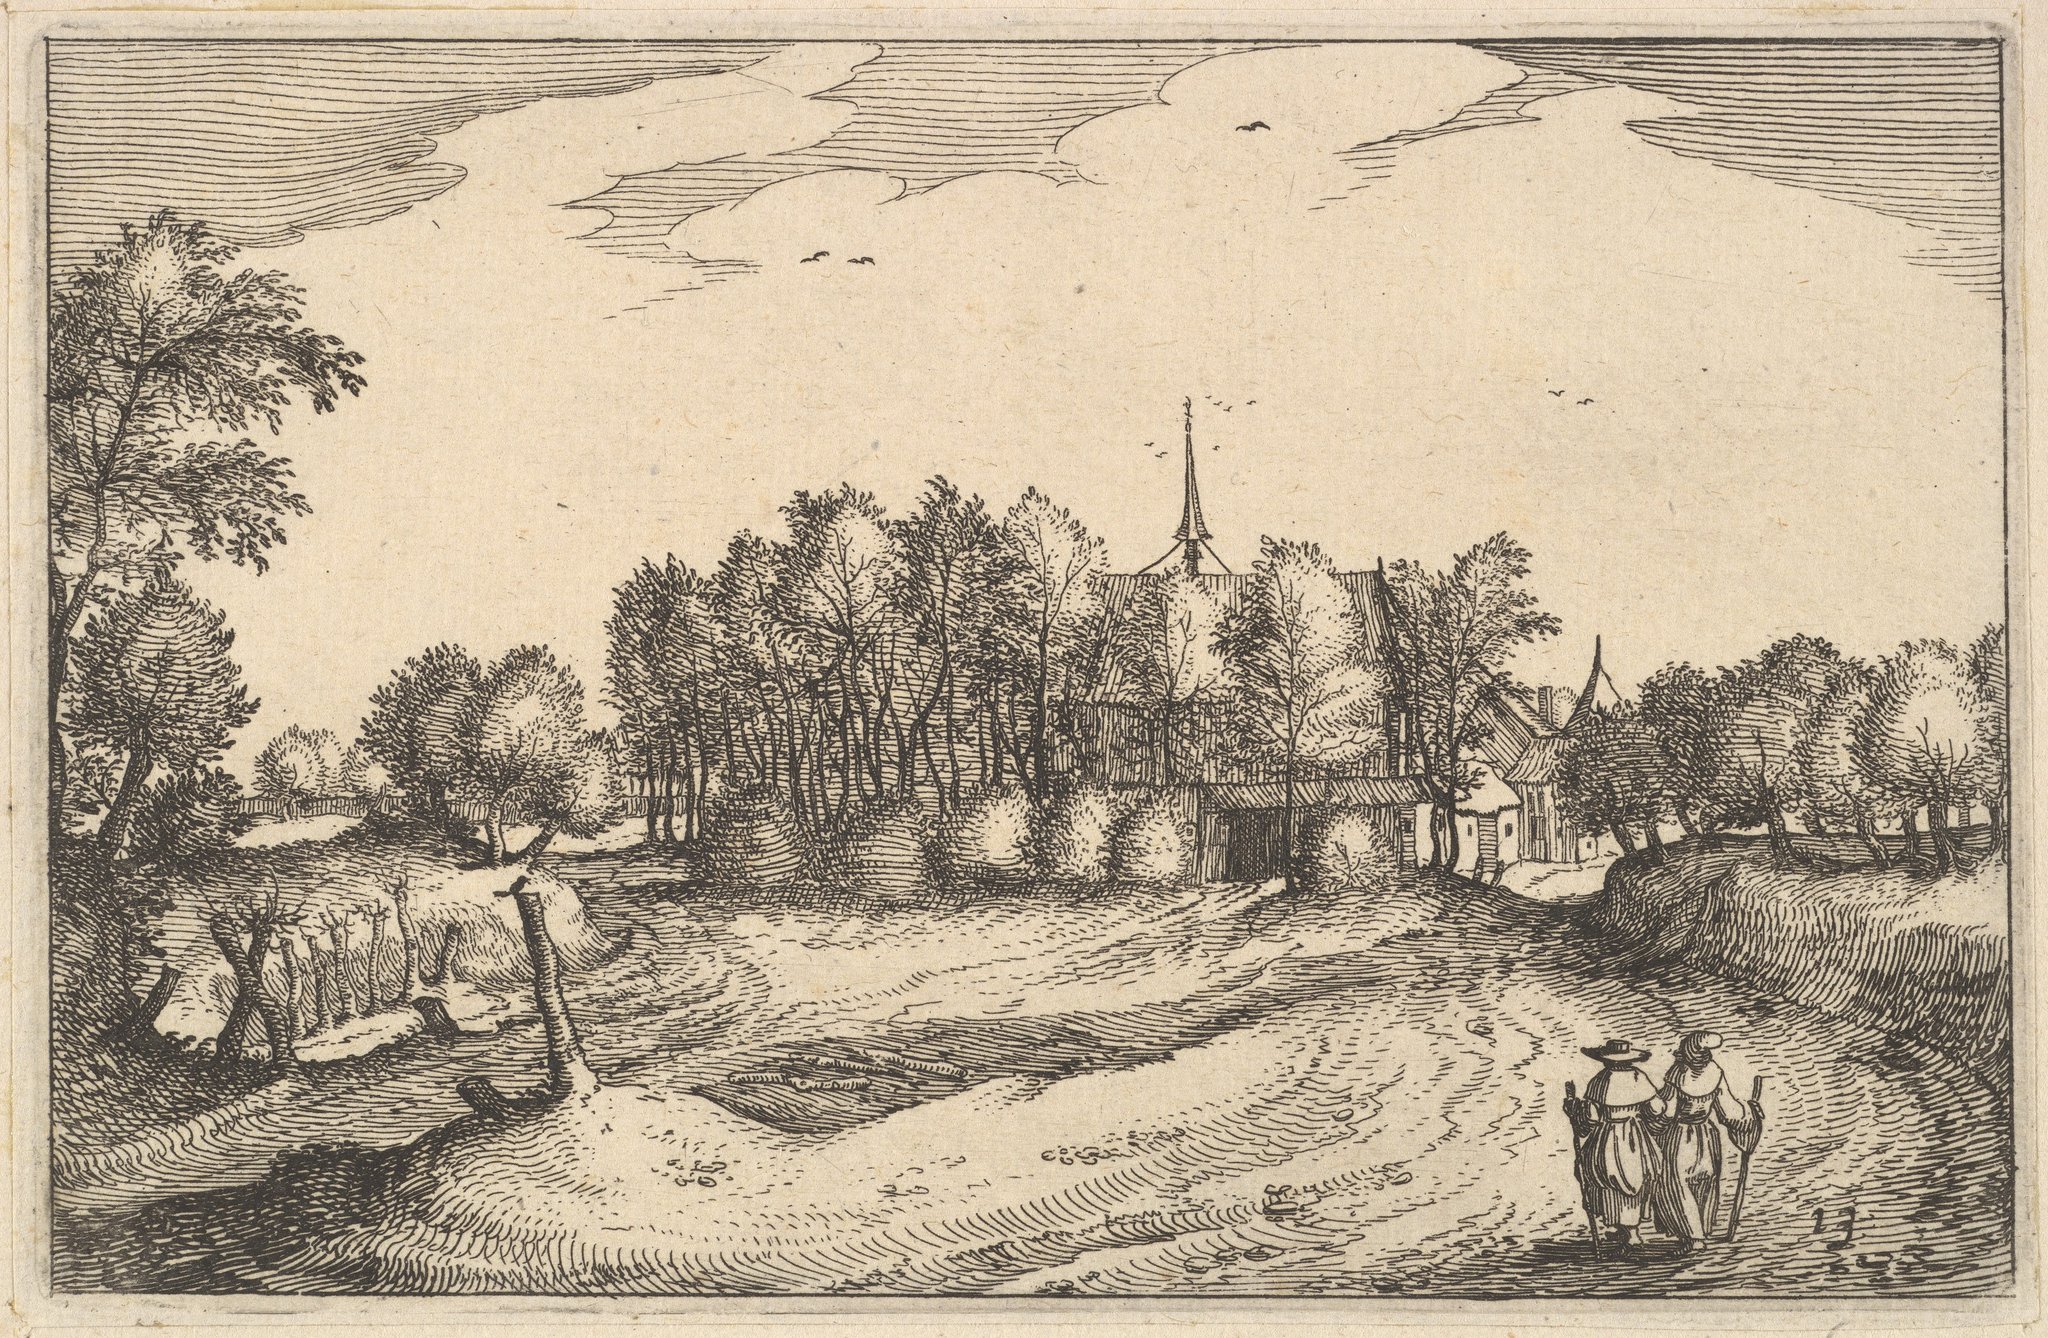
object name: print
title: A Convent, plate 13 from "Regiunculae et Villae Aliquot Ducatus Brabantiae"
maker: claes jansz. visscher (ii)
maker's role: artist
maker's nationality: dutch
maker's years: 1586-1652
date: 1610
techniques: etching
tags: human figures,villages,trees